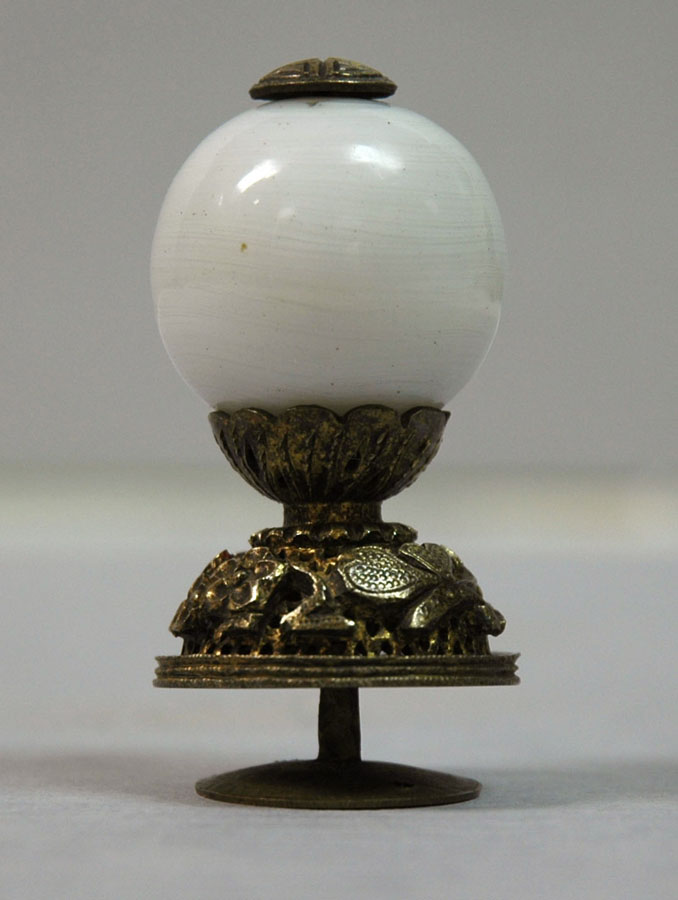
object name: hat finial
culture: chinese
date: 1644-1911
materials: glass, metal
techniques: gilding